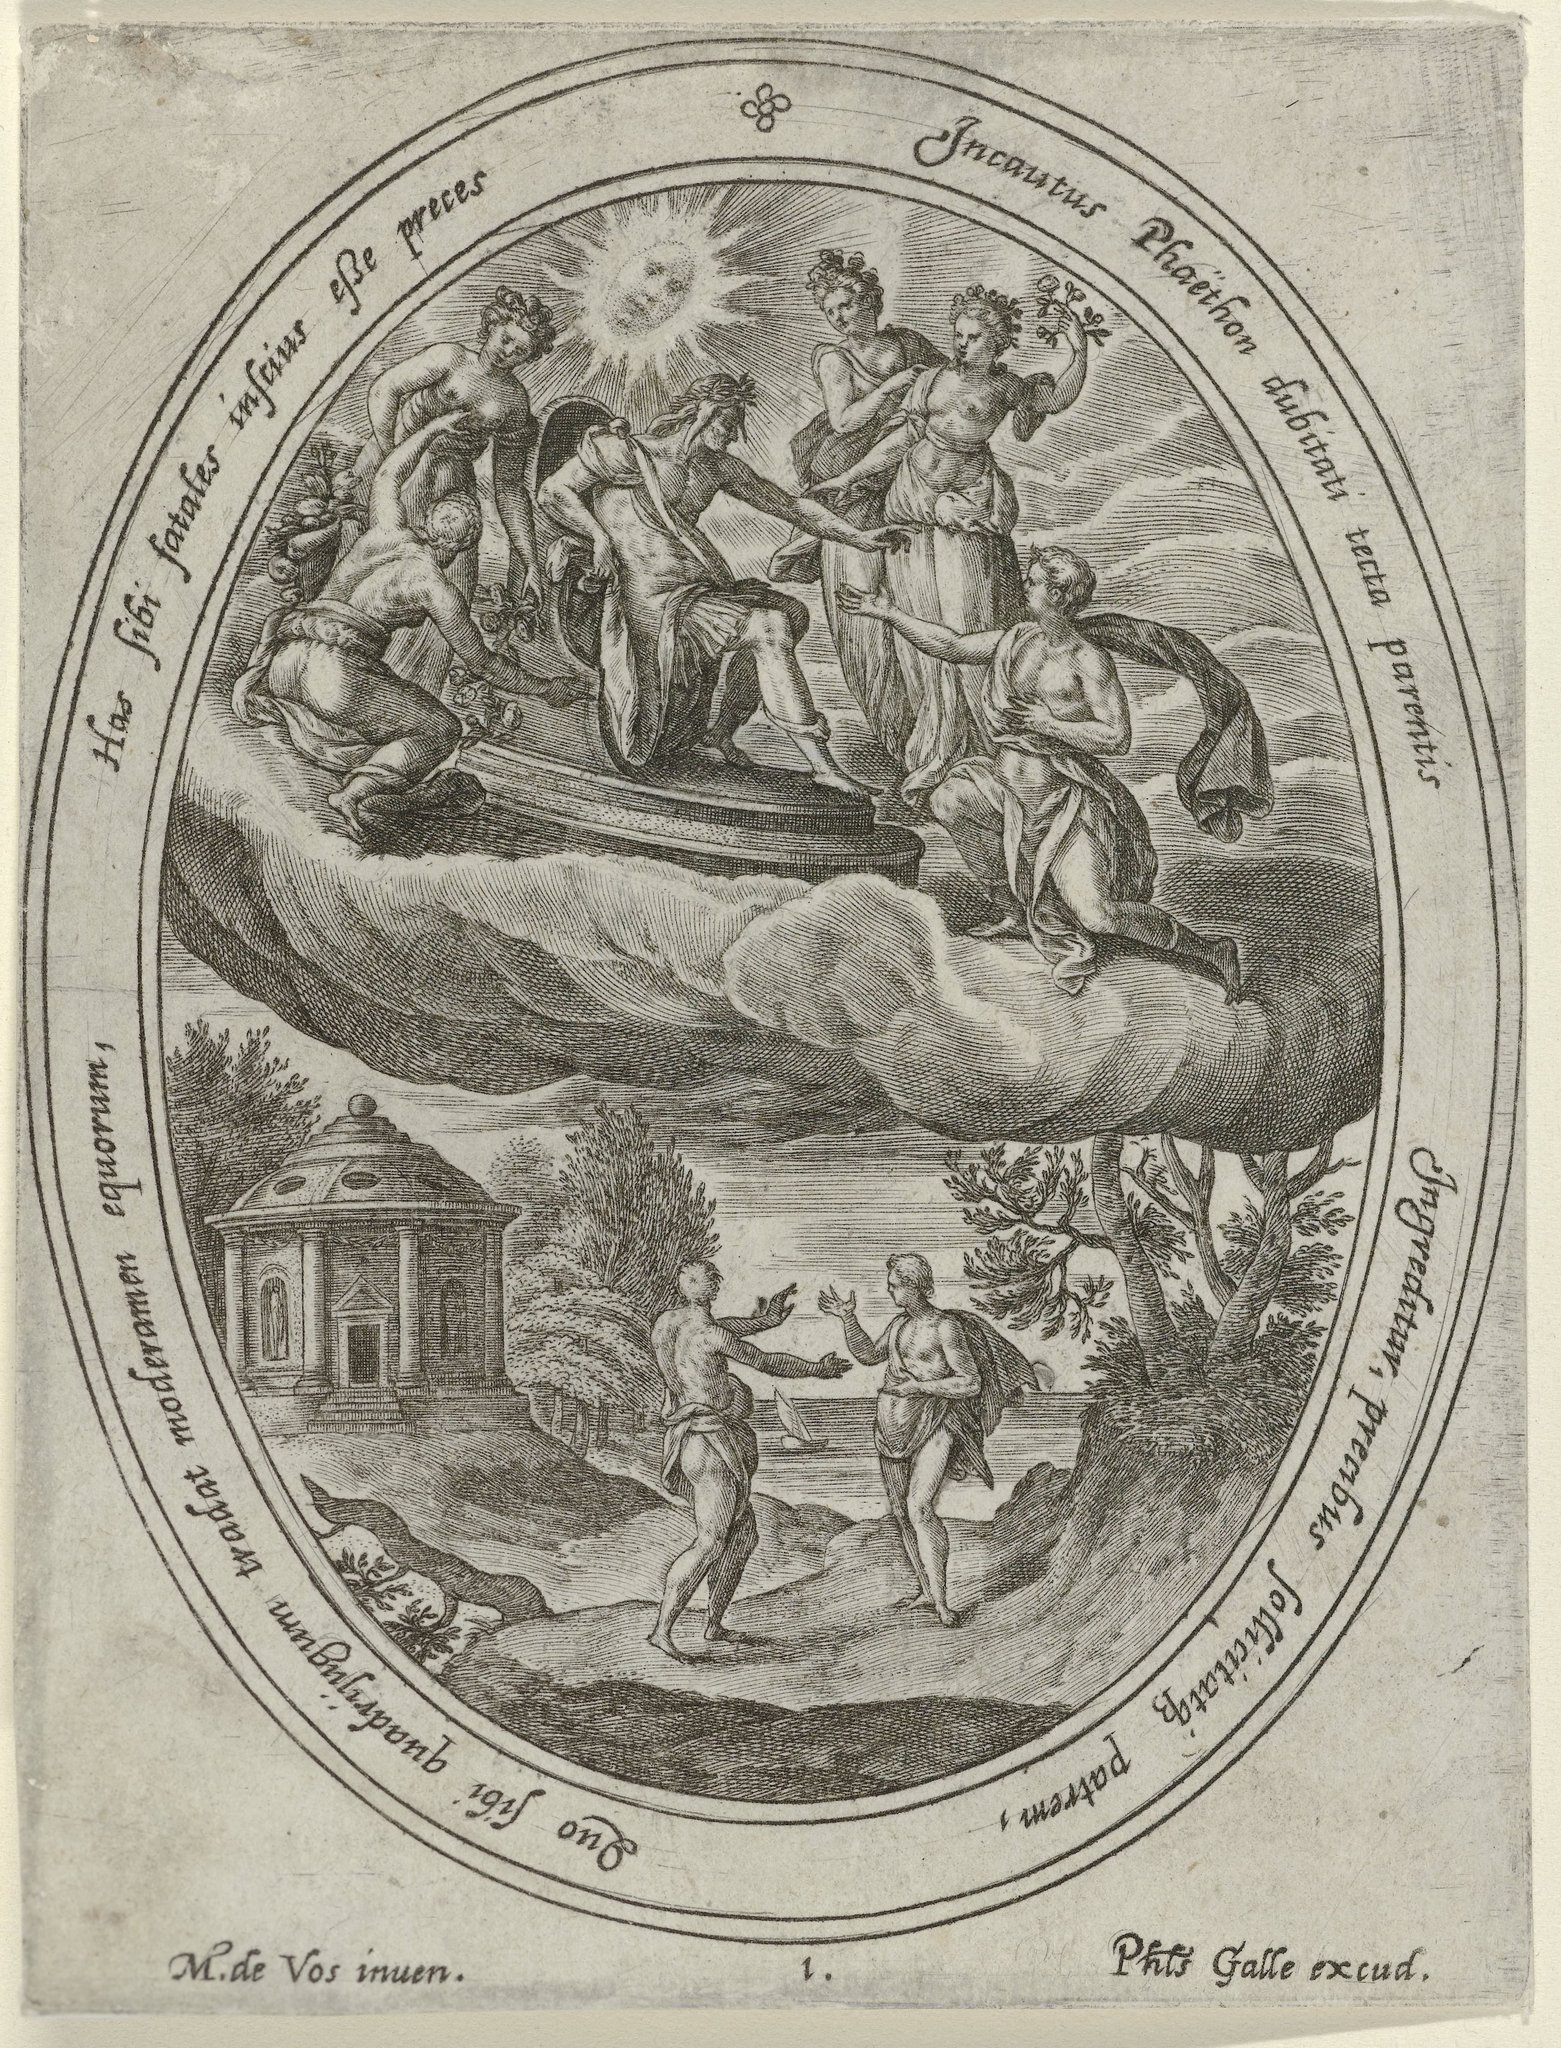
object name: print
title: Het verhaal van Phaëthon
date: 1542-1603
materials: paper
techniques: engraving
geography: antwerp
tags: phaethon asks apollo (sol) for the chariot of the sun, phaethon is taunted with not having a father, by epaphus, son of io and jupiter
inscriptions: collector's mark: Lugt 2760, collector's mark: Lugt 2228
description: In een ovale lijst een afbeelding: Apollo zit in een troon in de wolken. Rondom hem de vier jaargetijden. Zijn zoon, Phaëthon, knielt voor hem en vraagt of hij in de zonnewagen mag rijden. Onder de wolken is Phaëthon in debat met Epaphus voor een tempel. Epaphus gelooft niet dat hij de zoon van Apollo is. In de ovale lijst een Latijnse tekst. De prent is deel van een serie die het verhaal van Phaëthon afbeeldt.